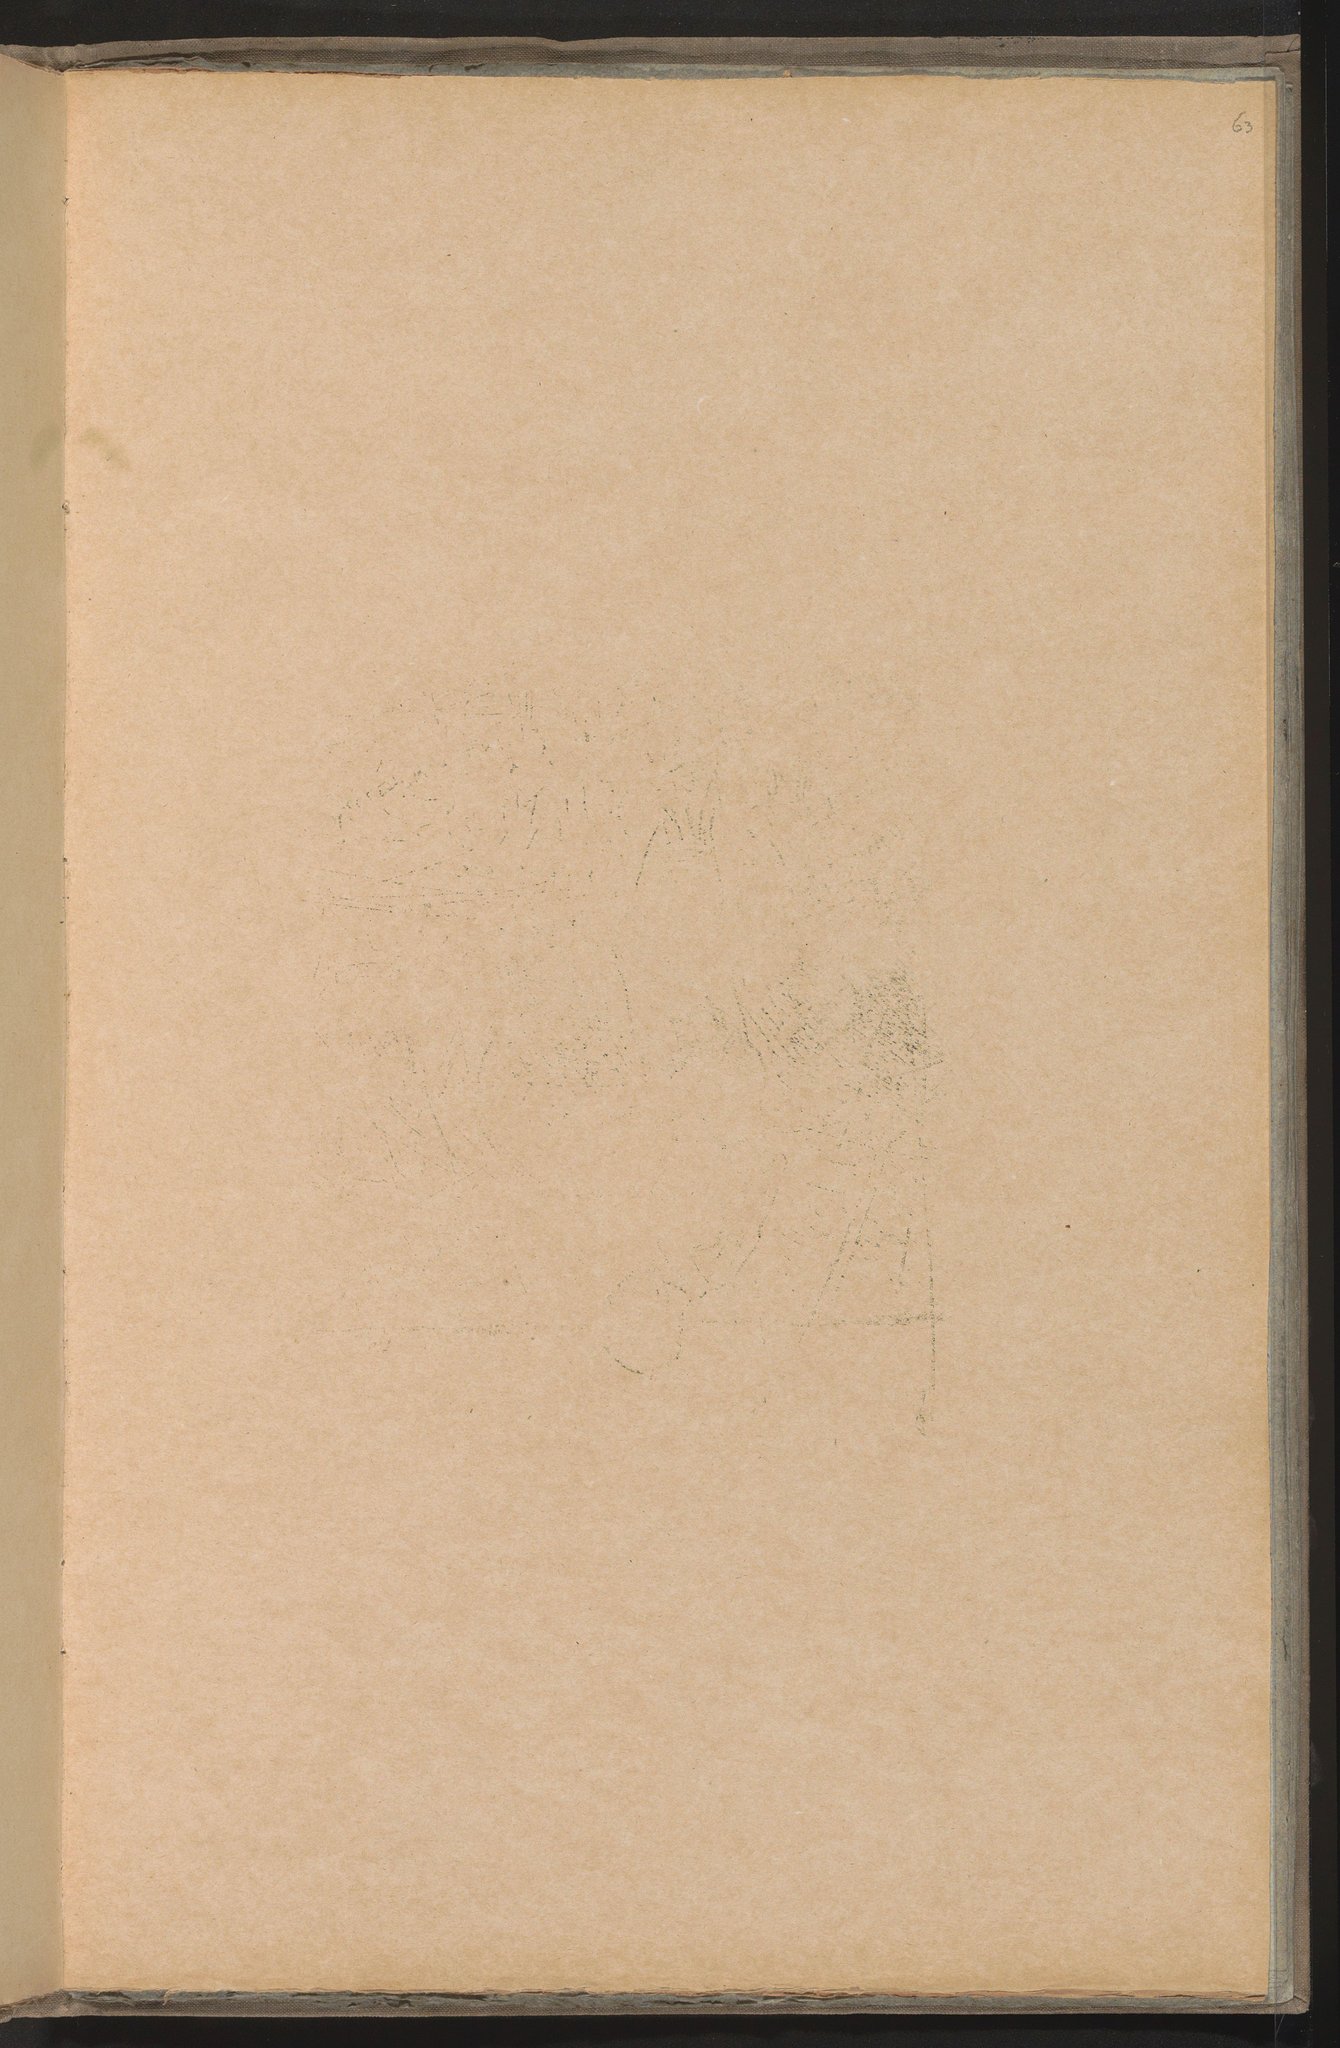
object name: sketchbook leaf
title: Abklatsch van een tekening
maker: willem witsen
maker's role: draughtsman, painter, print maker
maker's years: 1860-1923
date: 1884-1887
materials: paper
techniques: printmaking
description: Mogelijk een man in een landschap. Pagina 63 uit een schetsboek met 38 bladen.